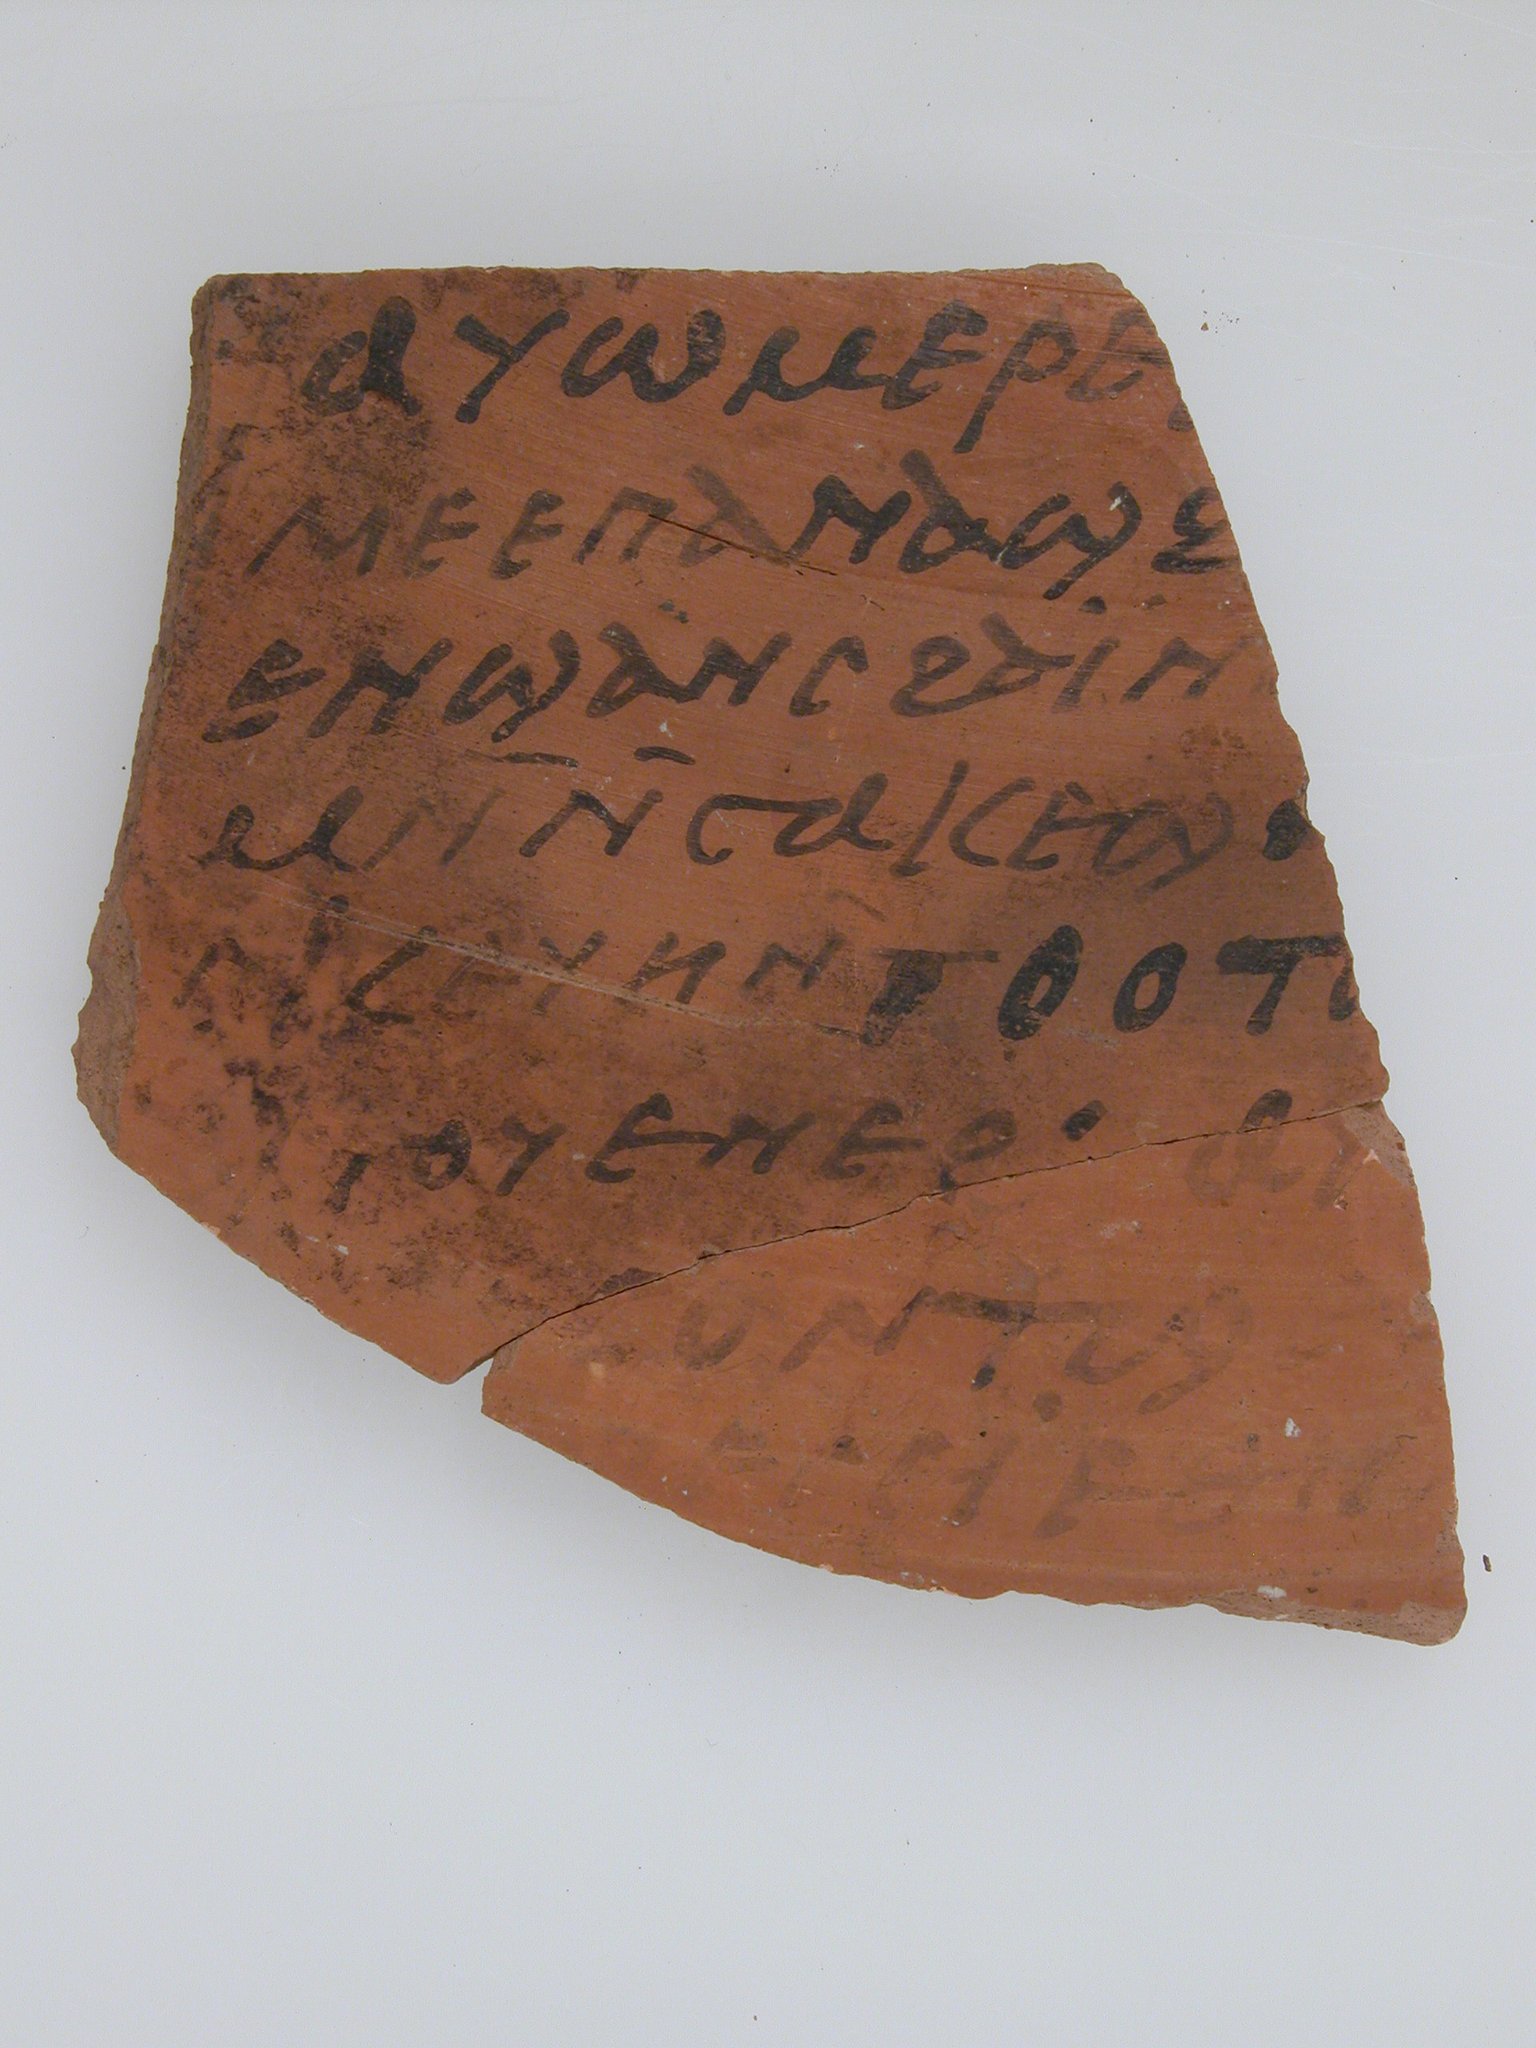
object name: ostrakon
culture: coptic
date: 600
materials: ink, pottery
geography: egypt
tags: coptic,documents